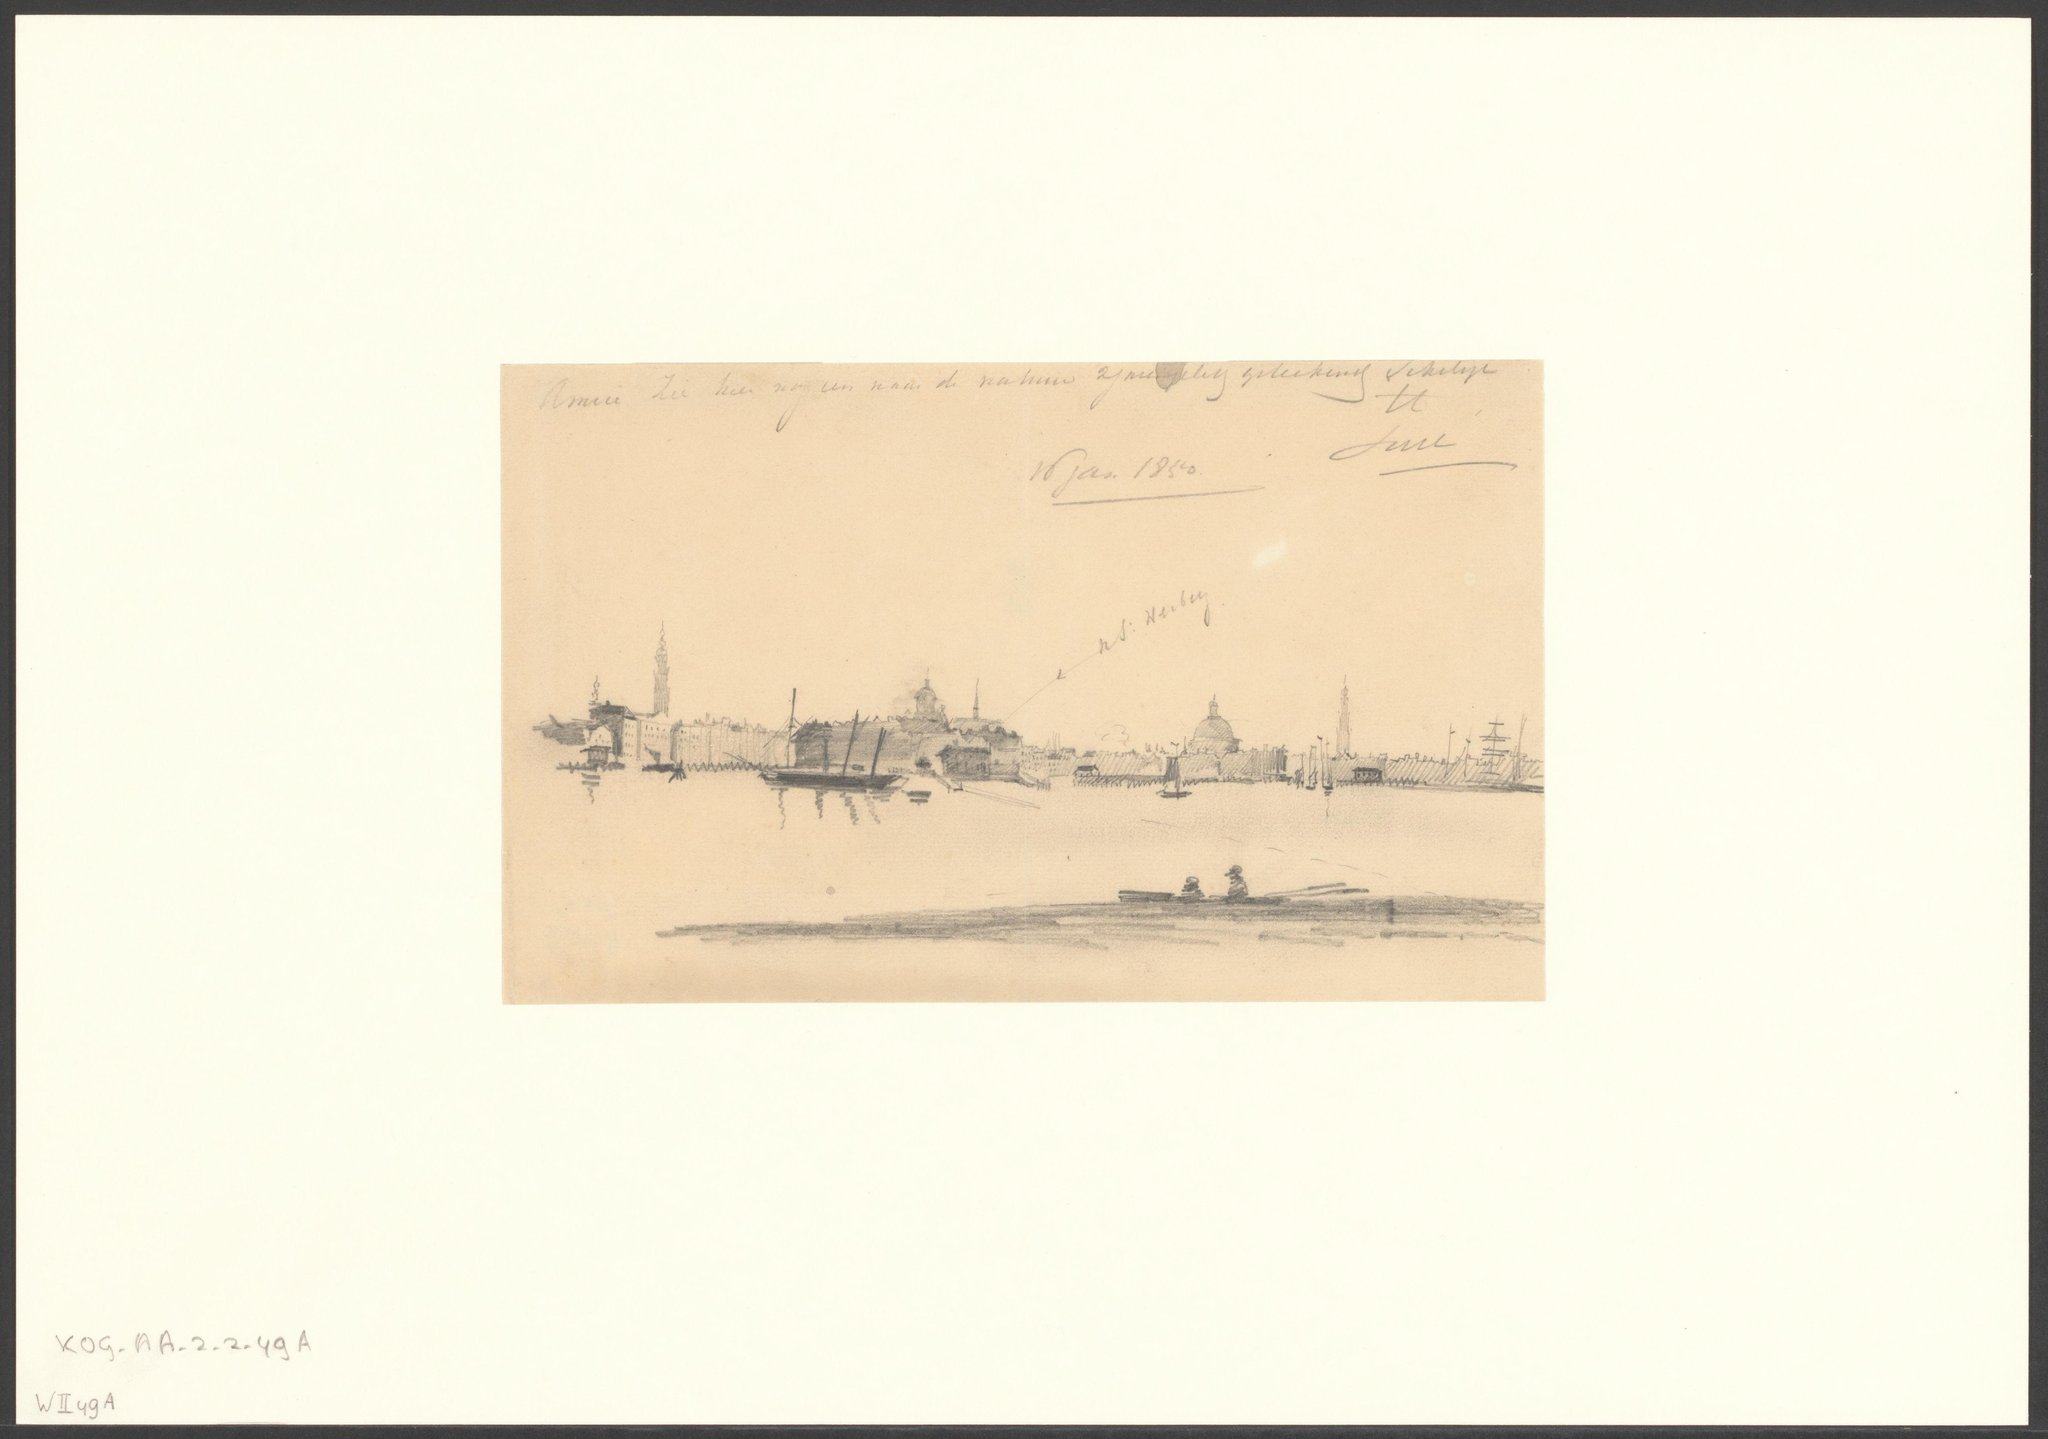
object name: drawing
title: Gezicht op Amsterdam vanaf Volewijk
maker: Anonymous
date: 1850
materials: paper, pencil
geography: amsterdam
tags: city-view in general; 'veduta', river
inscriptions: inscription: ‘Amici Zie hier nog een naar de natuur [...] schenking (?) [...] / tot / Juni / ns: Herberg.’, date: ‘16 jan 1850’, collector's mark: Lugt 800a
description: Tekening binnen de Atlas Van Eck ingedeeld op wijknummer 2.